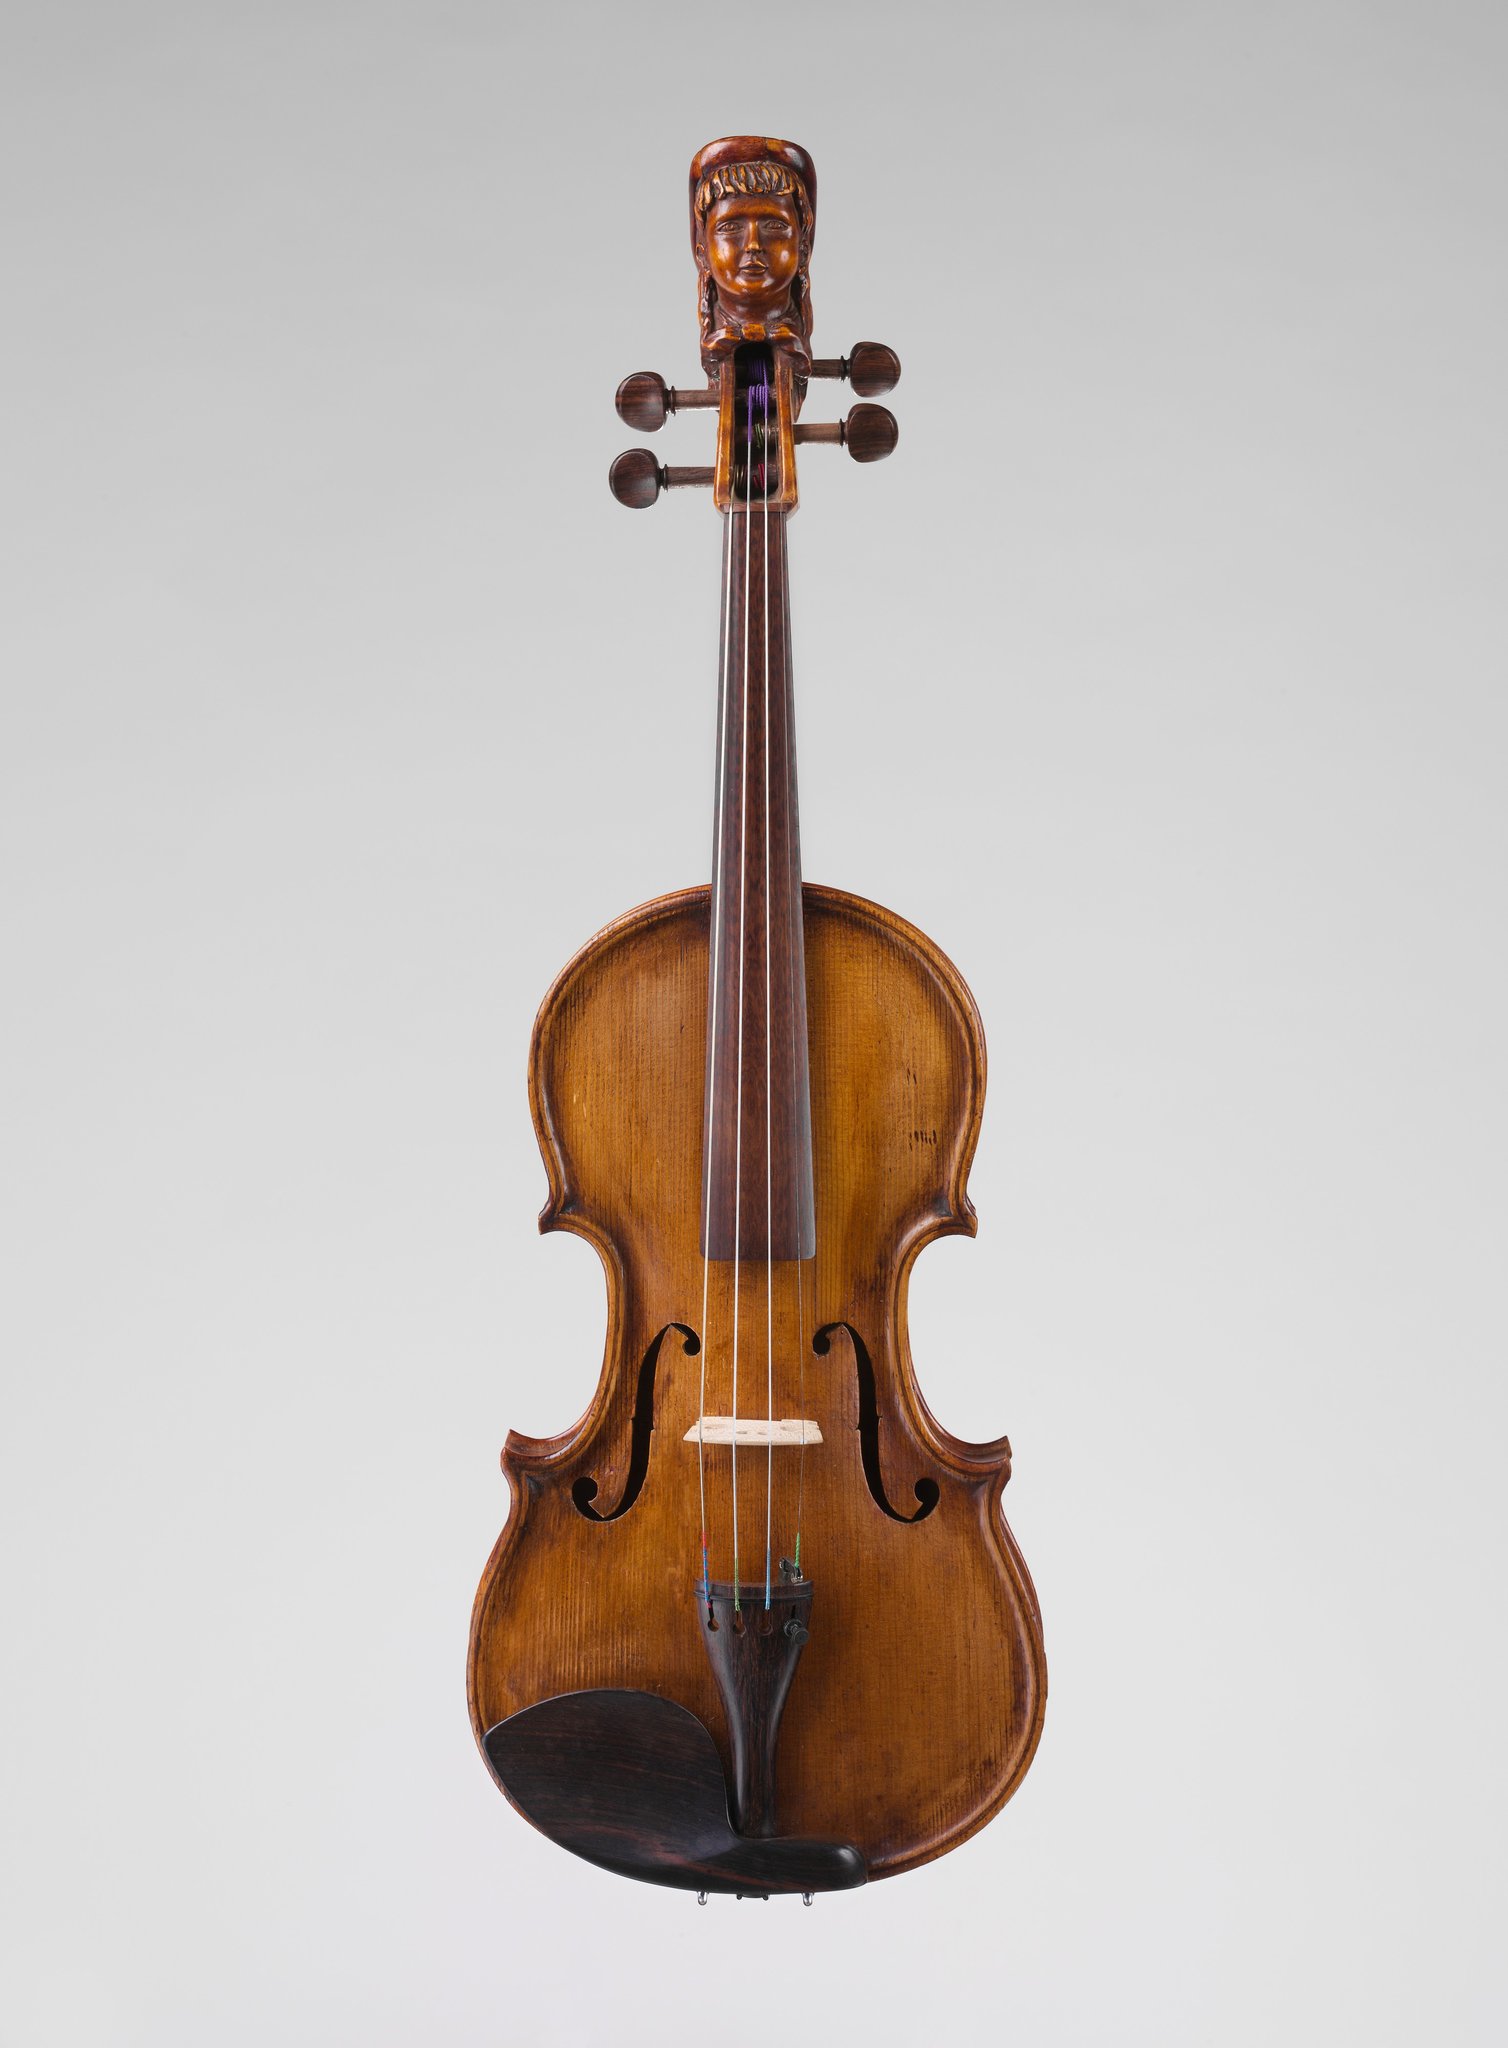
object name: violin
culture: american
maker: philip henry holmes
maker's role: maker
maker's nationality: american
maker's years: 1845-1915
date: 1885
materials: wood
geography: united states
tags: heads